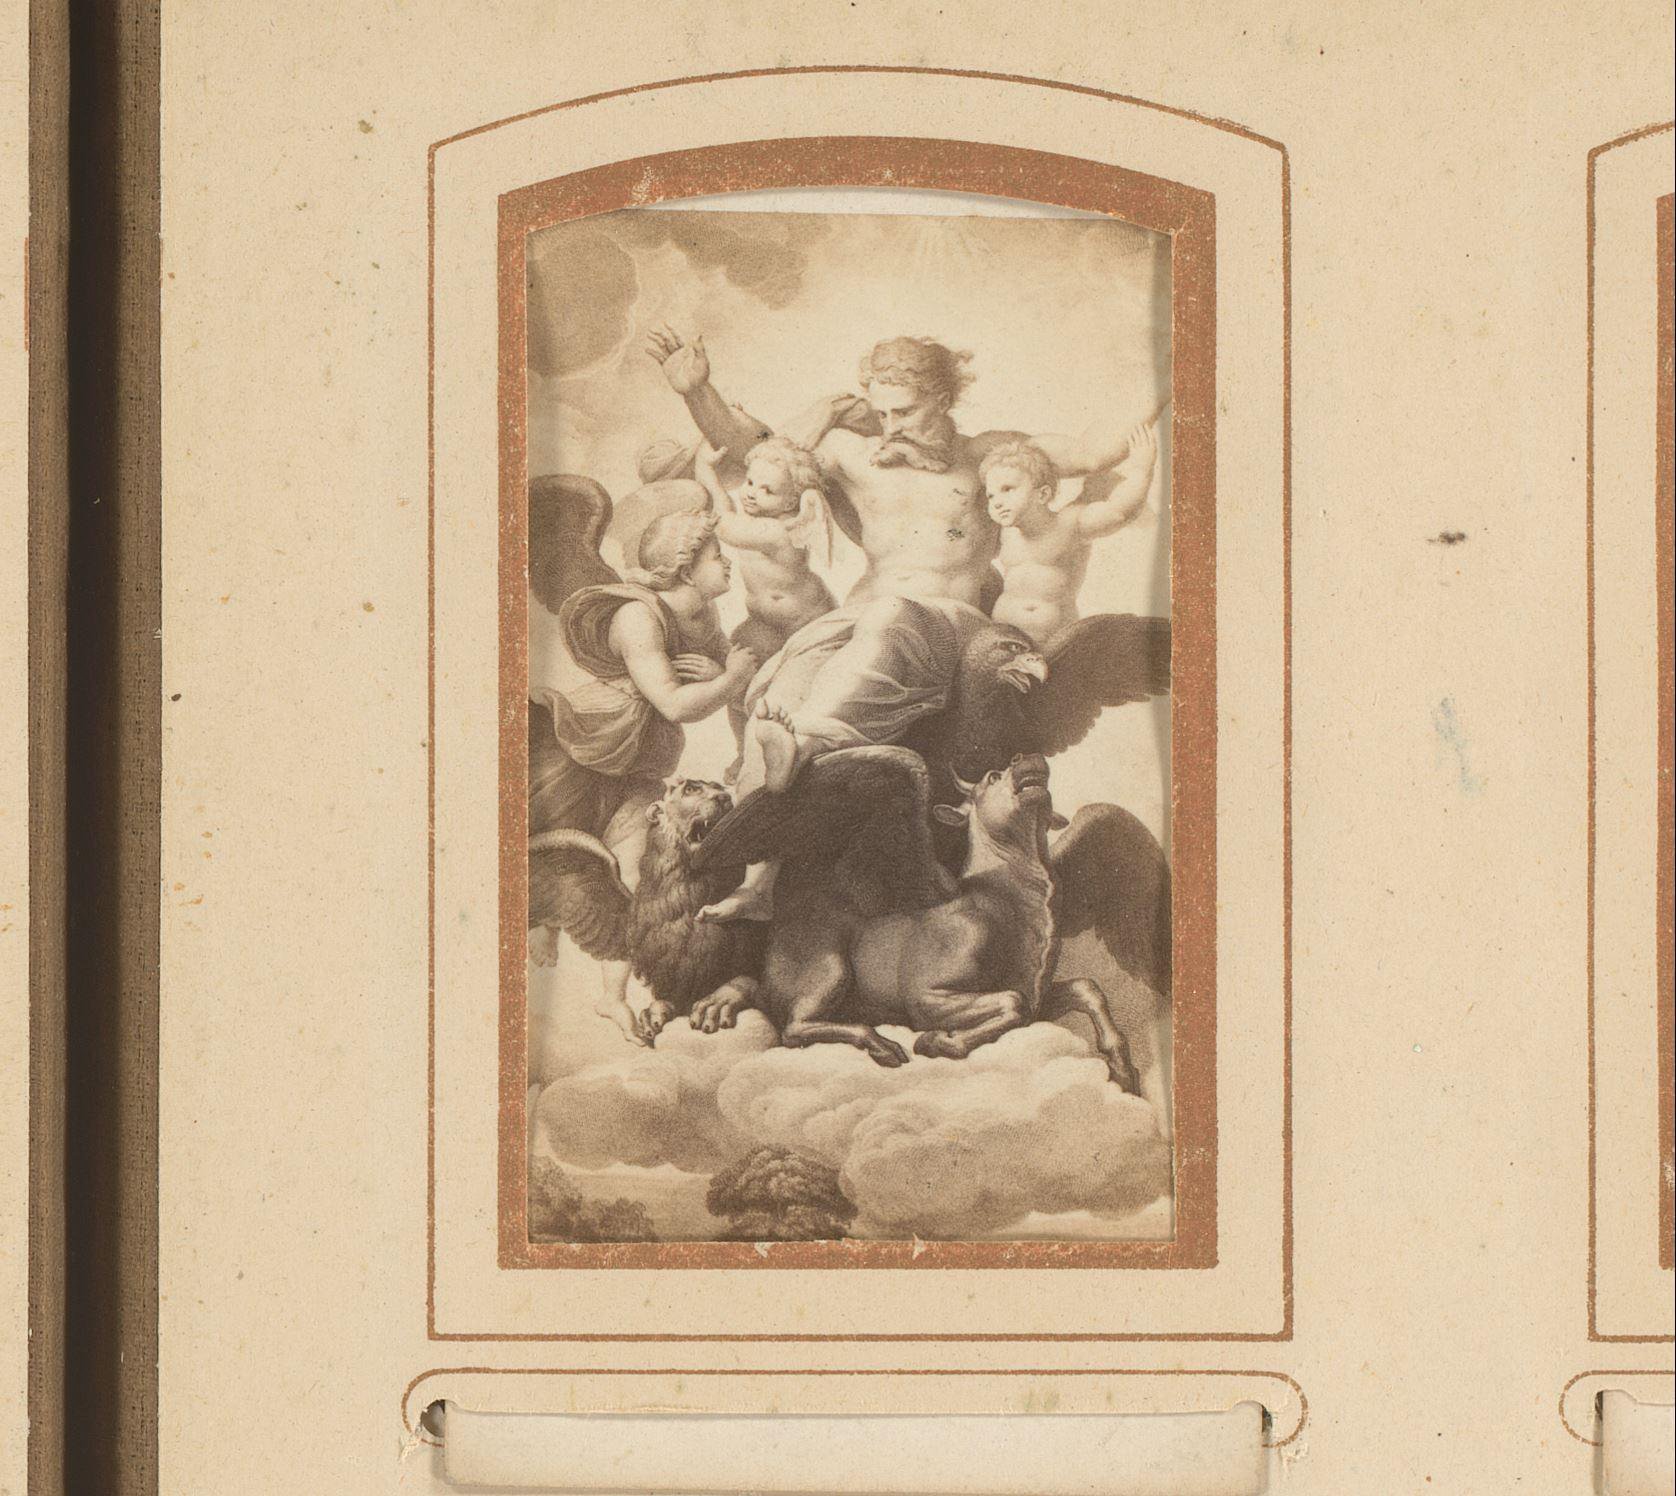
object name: reproduction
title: Fotoreproductie van Het visioen van Ezechiël door Rafaël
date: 1850-1900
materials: cardboard, photographic support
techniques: albumen print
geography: berlin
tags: ezekiel's vision of god sitting on his throne carried by four tetramorphs, each of them having four wings; wheels within wheels beside them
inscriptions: inscription: ‘Gustav Schauer/ Photographisches Kunst- und Verlags - Institut/ BERLIN/ Grosse Friedrichs - Strasse 188.’, inscription: ‘Rafael:/ Vision des Ezechiel./ 351.’